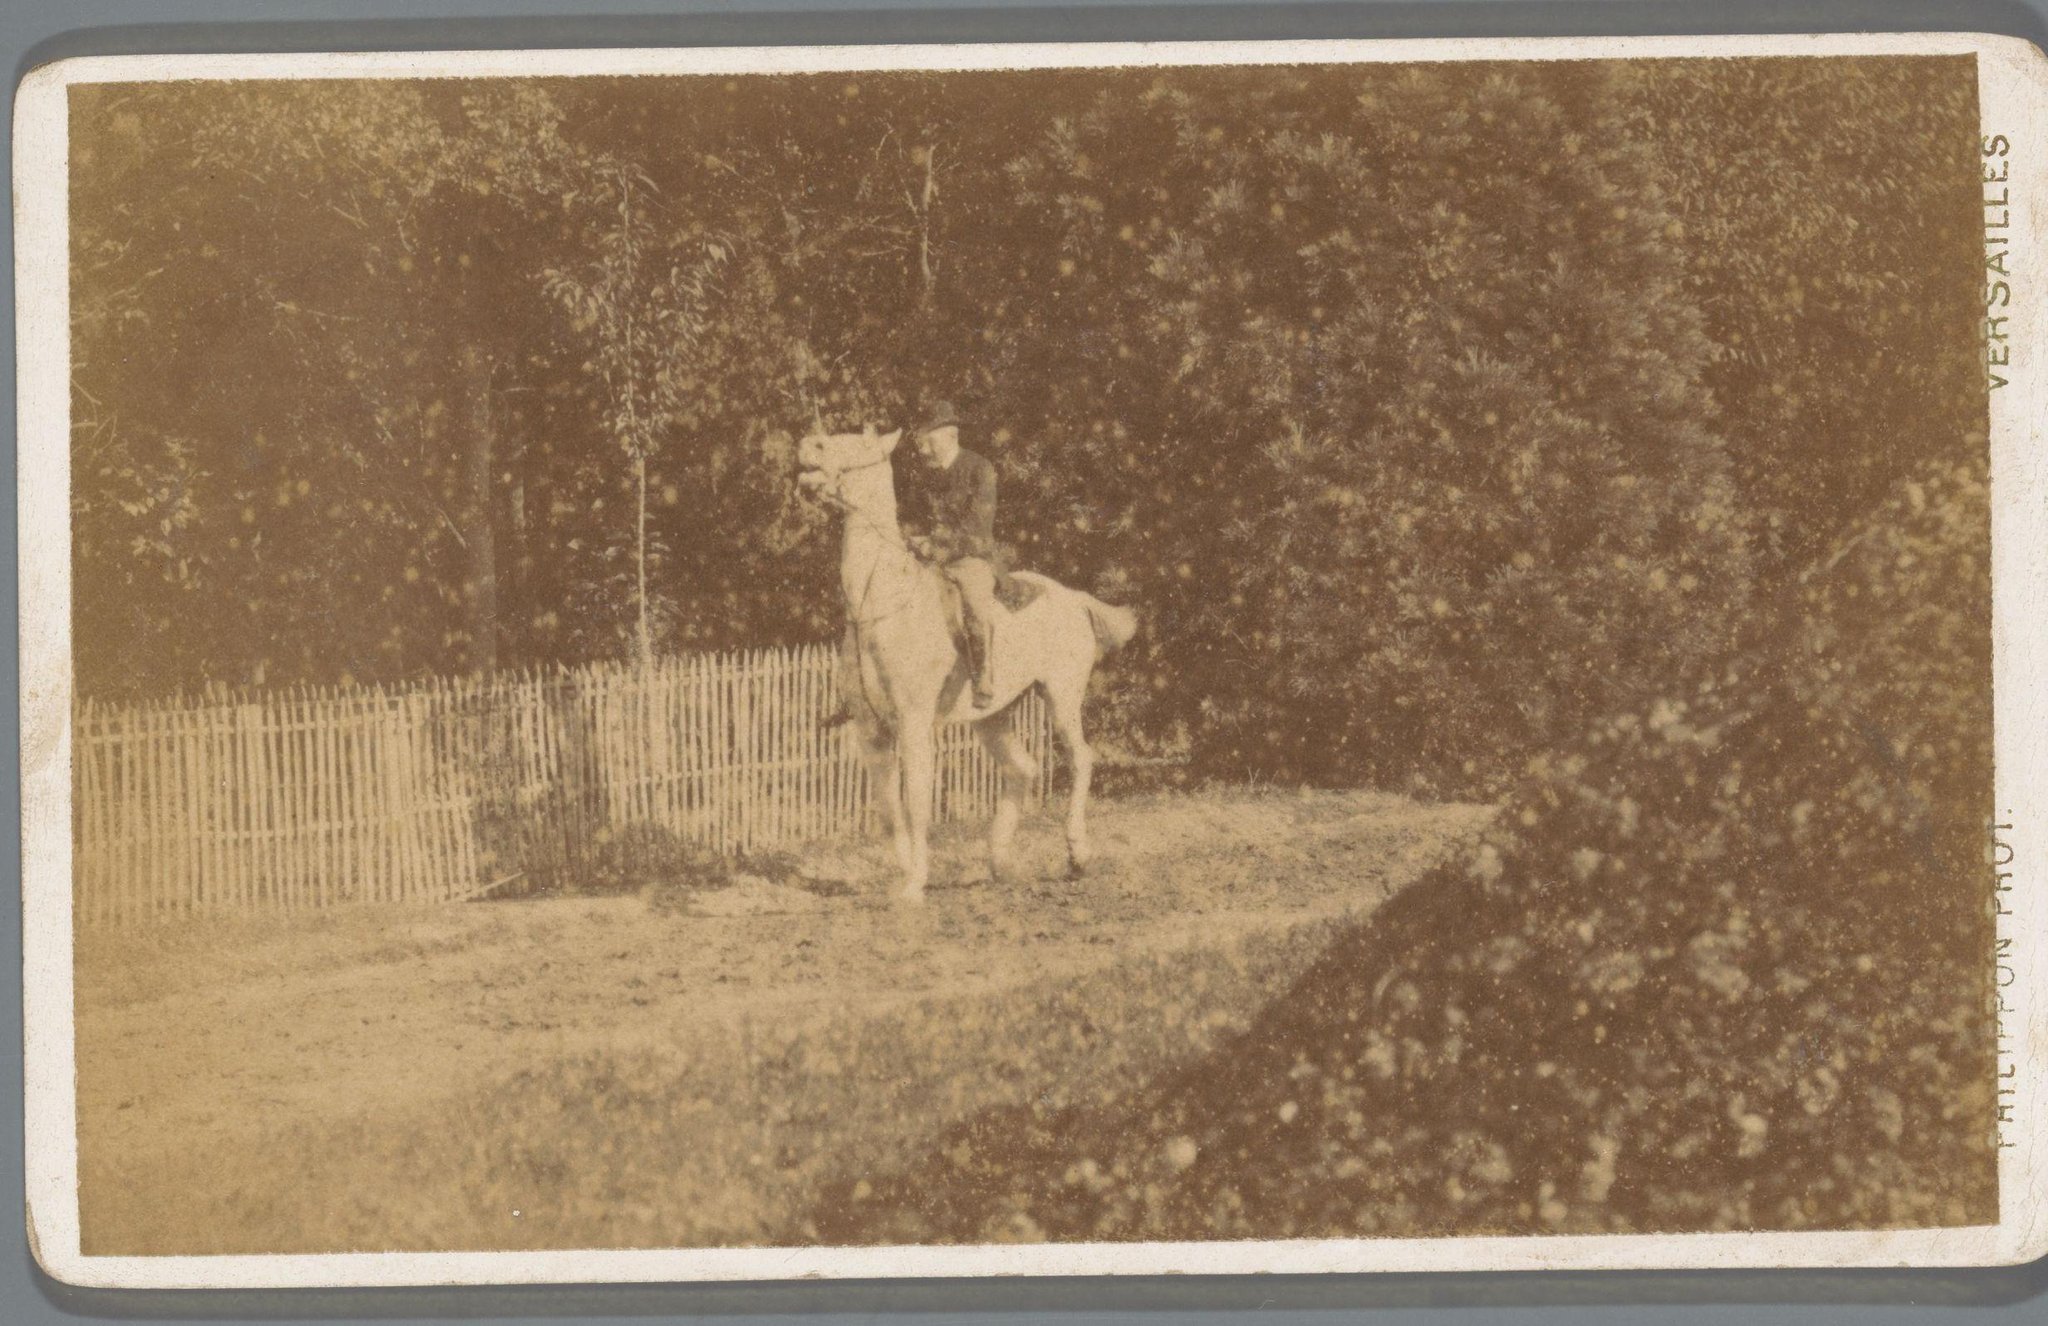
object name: carte de visite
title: Ruiter te paard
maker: cyrien dominique philippon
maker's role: fotograaf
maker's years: 1840-1891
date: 1872-1891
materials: cardboard, paper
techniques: albumen print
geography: versailles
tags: riding a horse, ass, or mule; rider, horseman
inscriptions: inscription: ‘Philippon phot. Versailles’, inscription: ‘Philippon/ 17, Rue Colbert/ Maison du Chemin de Fer Americain/ Versailles/ English Spoken’